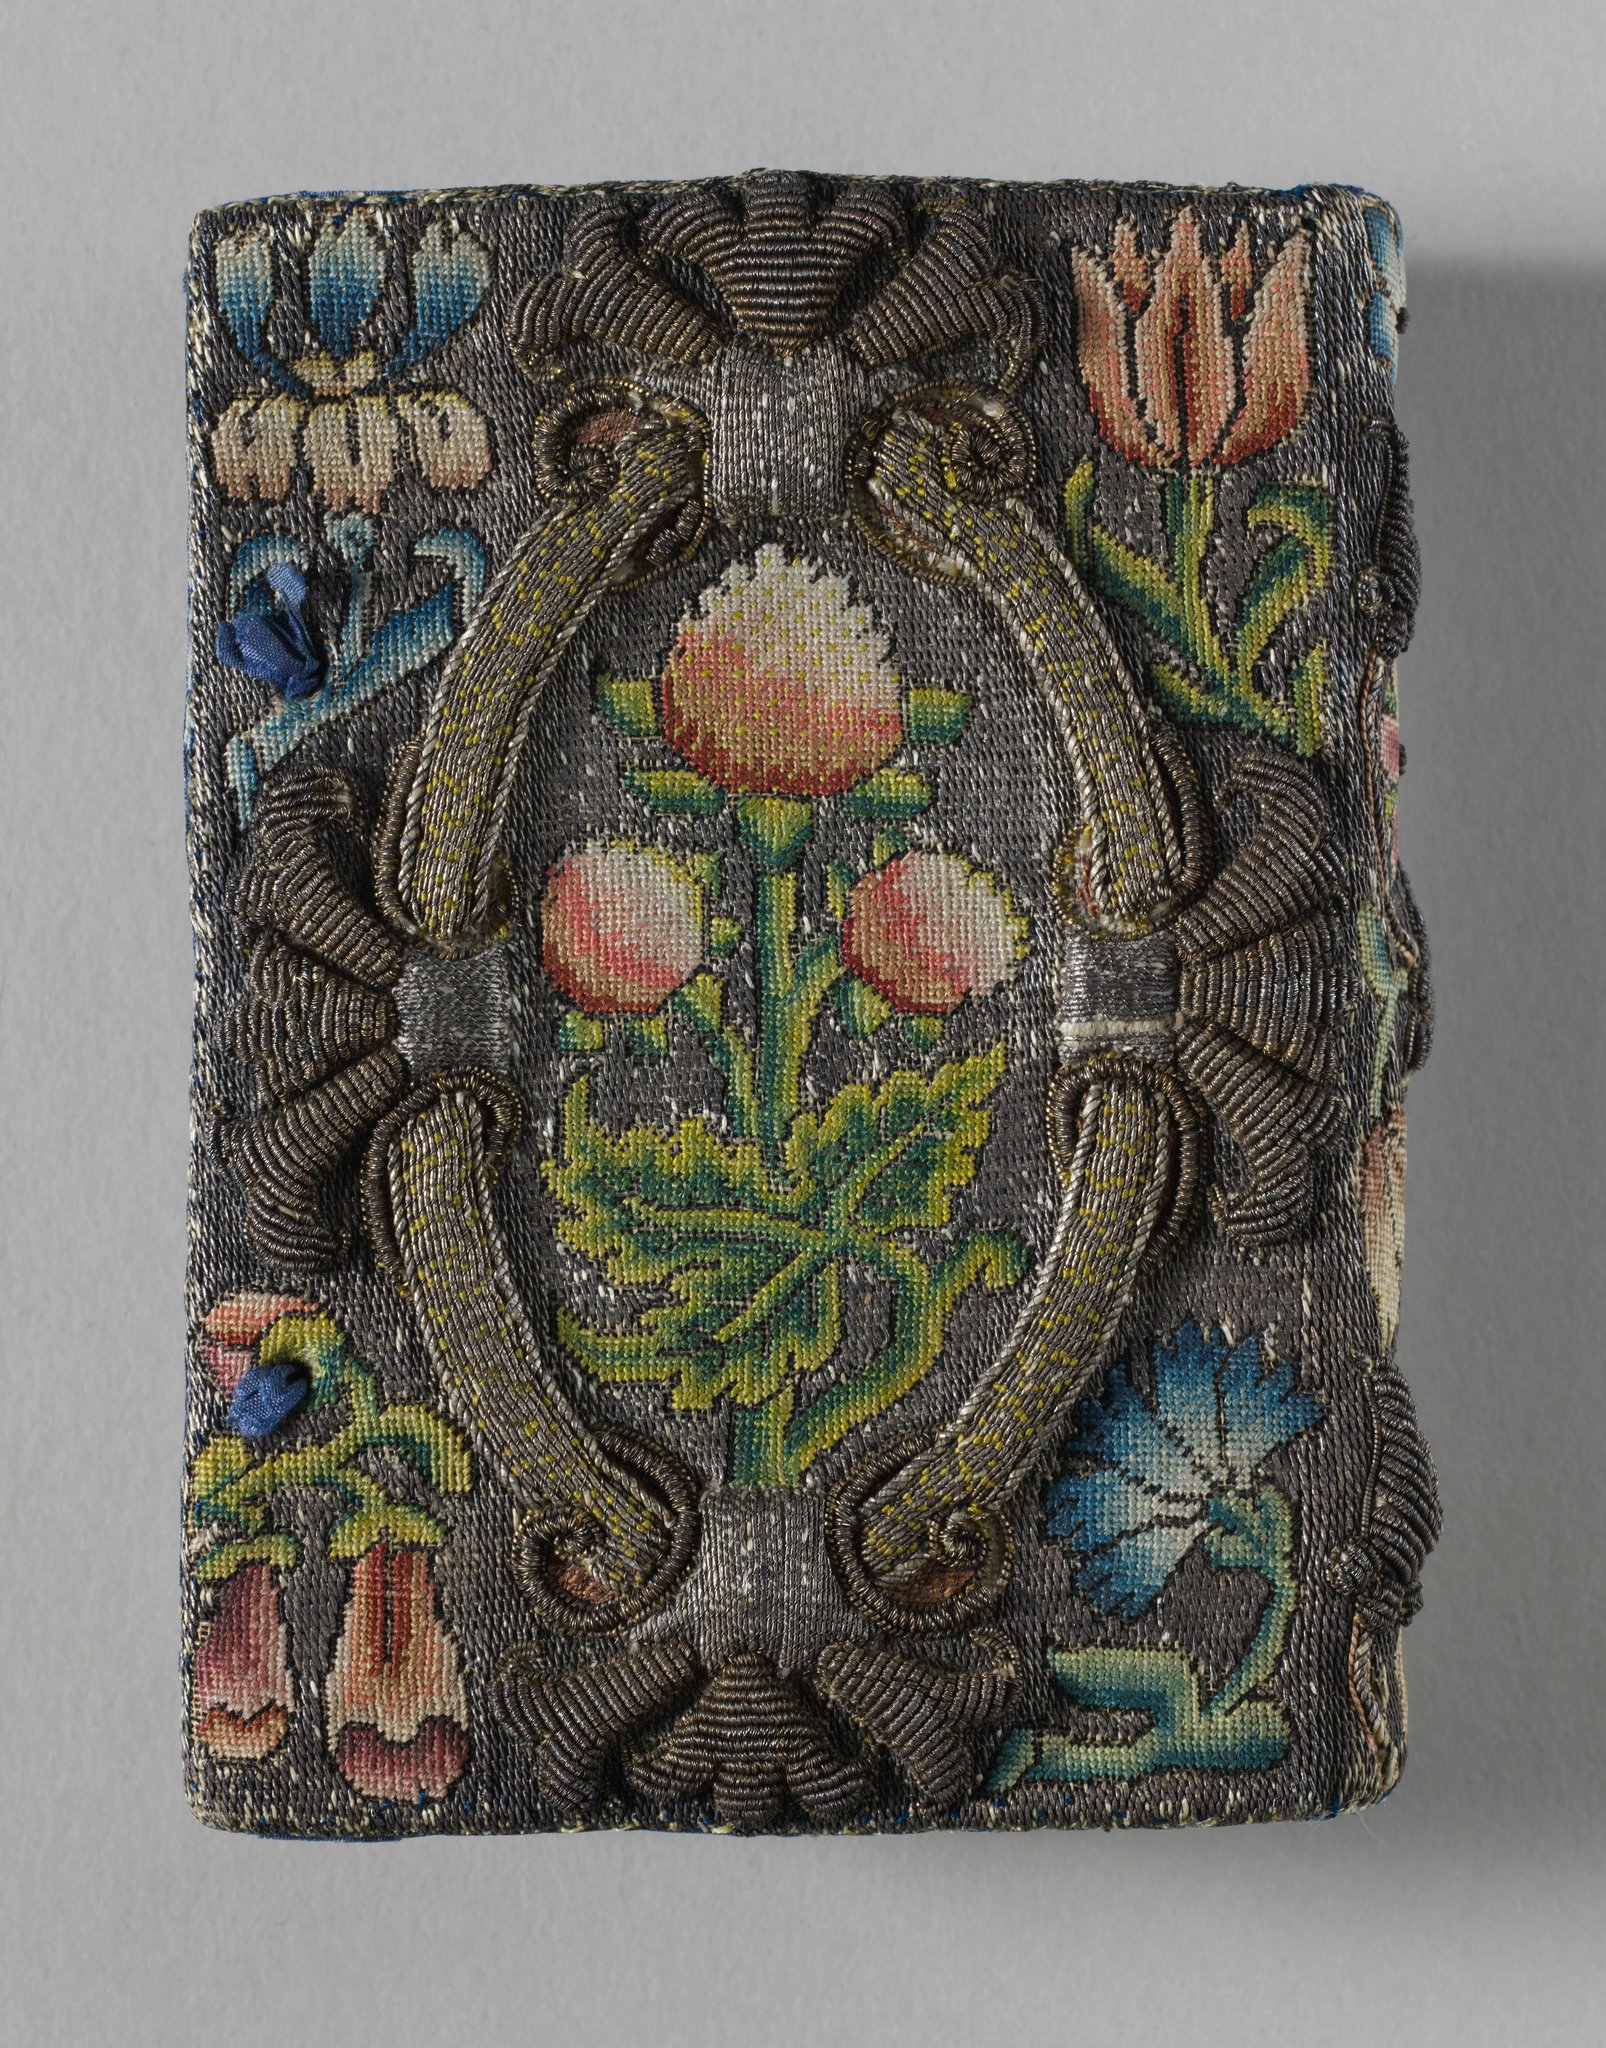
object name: book cover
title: The Whole Booke of Davids Psalmes, with an embroidered cover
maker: company of stationers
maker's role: printer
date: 1635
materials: canvas, metal thread, pearl, silk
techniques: embroidery, stitching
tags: flowers